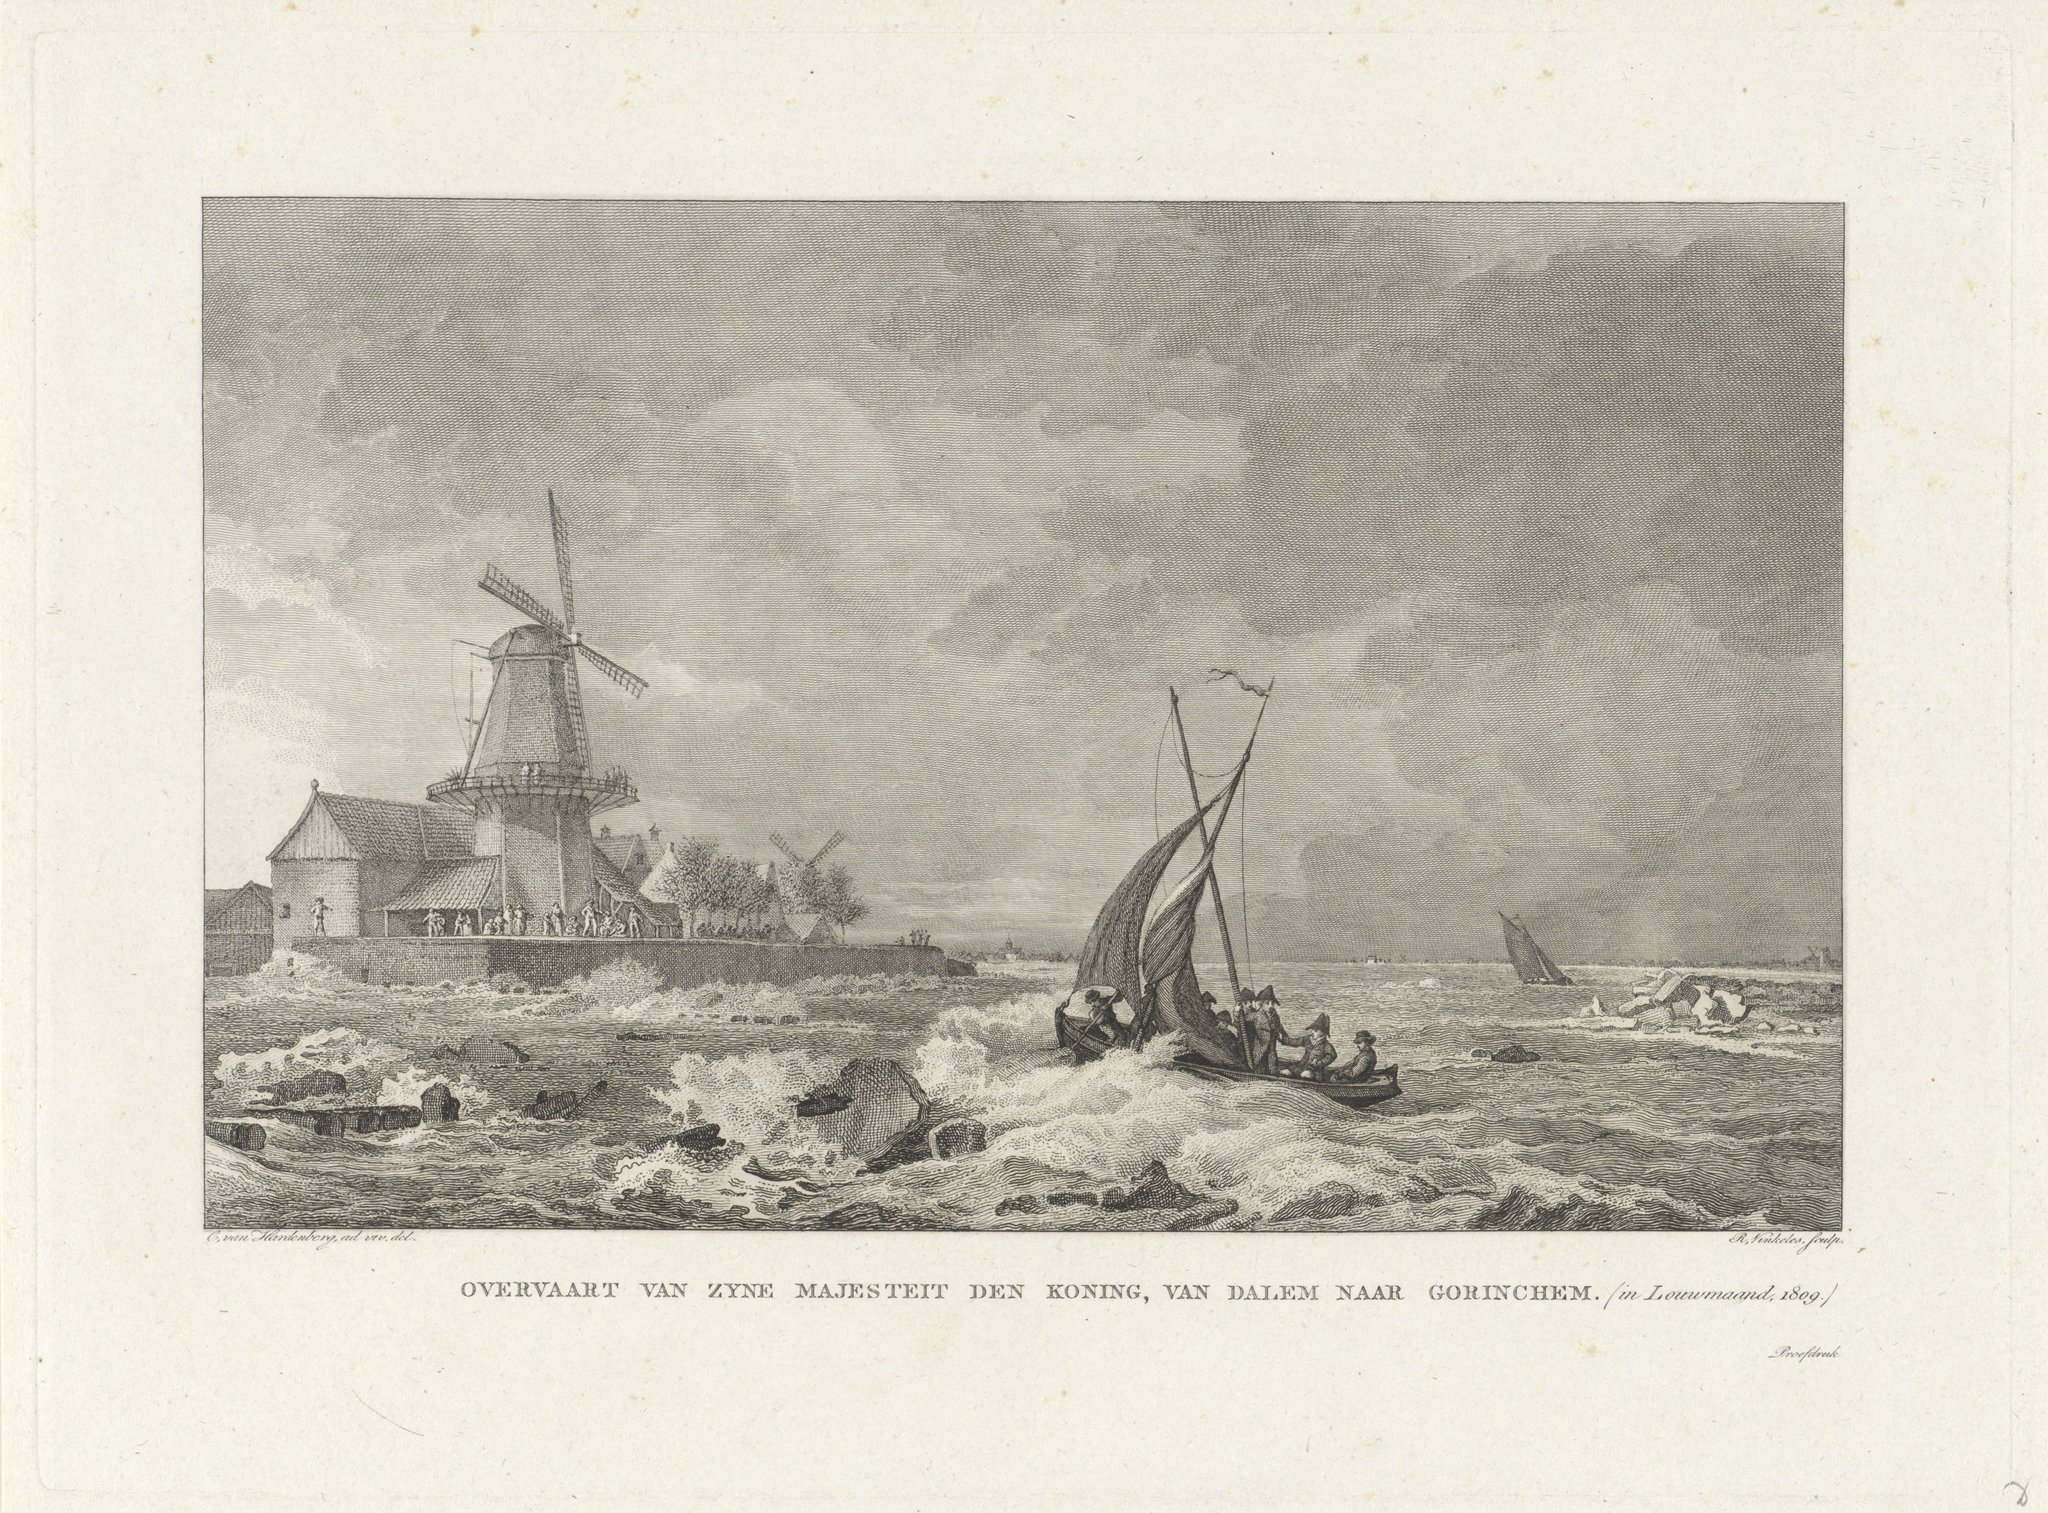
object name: print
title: Overvaart van zyne majesteit den koning, van Dalem naar Gorinchem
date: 1809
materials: paper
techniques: engraving, etching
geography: amsterdam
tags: louis napoleon (king of holland), flood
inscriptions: collector's mark: Lugt 2228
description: Illustratie voor: Ewijk, Hendrik. Geschiedkundig verslag der dijkbreuken en overstroomingen in Holland, in 1809. Amsterdam: J. Allart en J. Ruys, 1809. Niet beschreven bij Frederik Muller (5754).